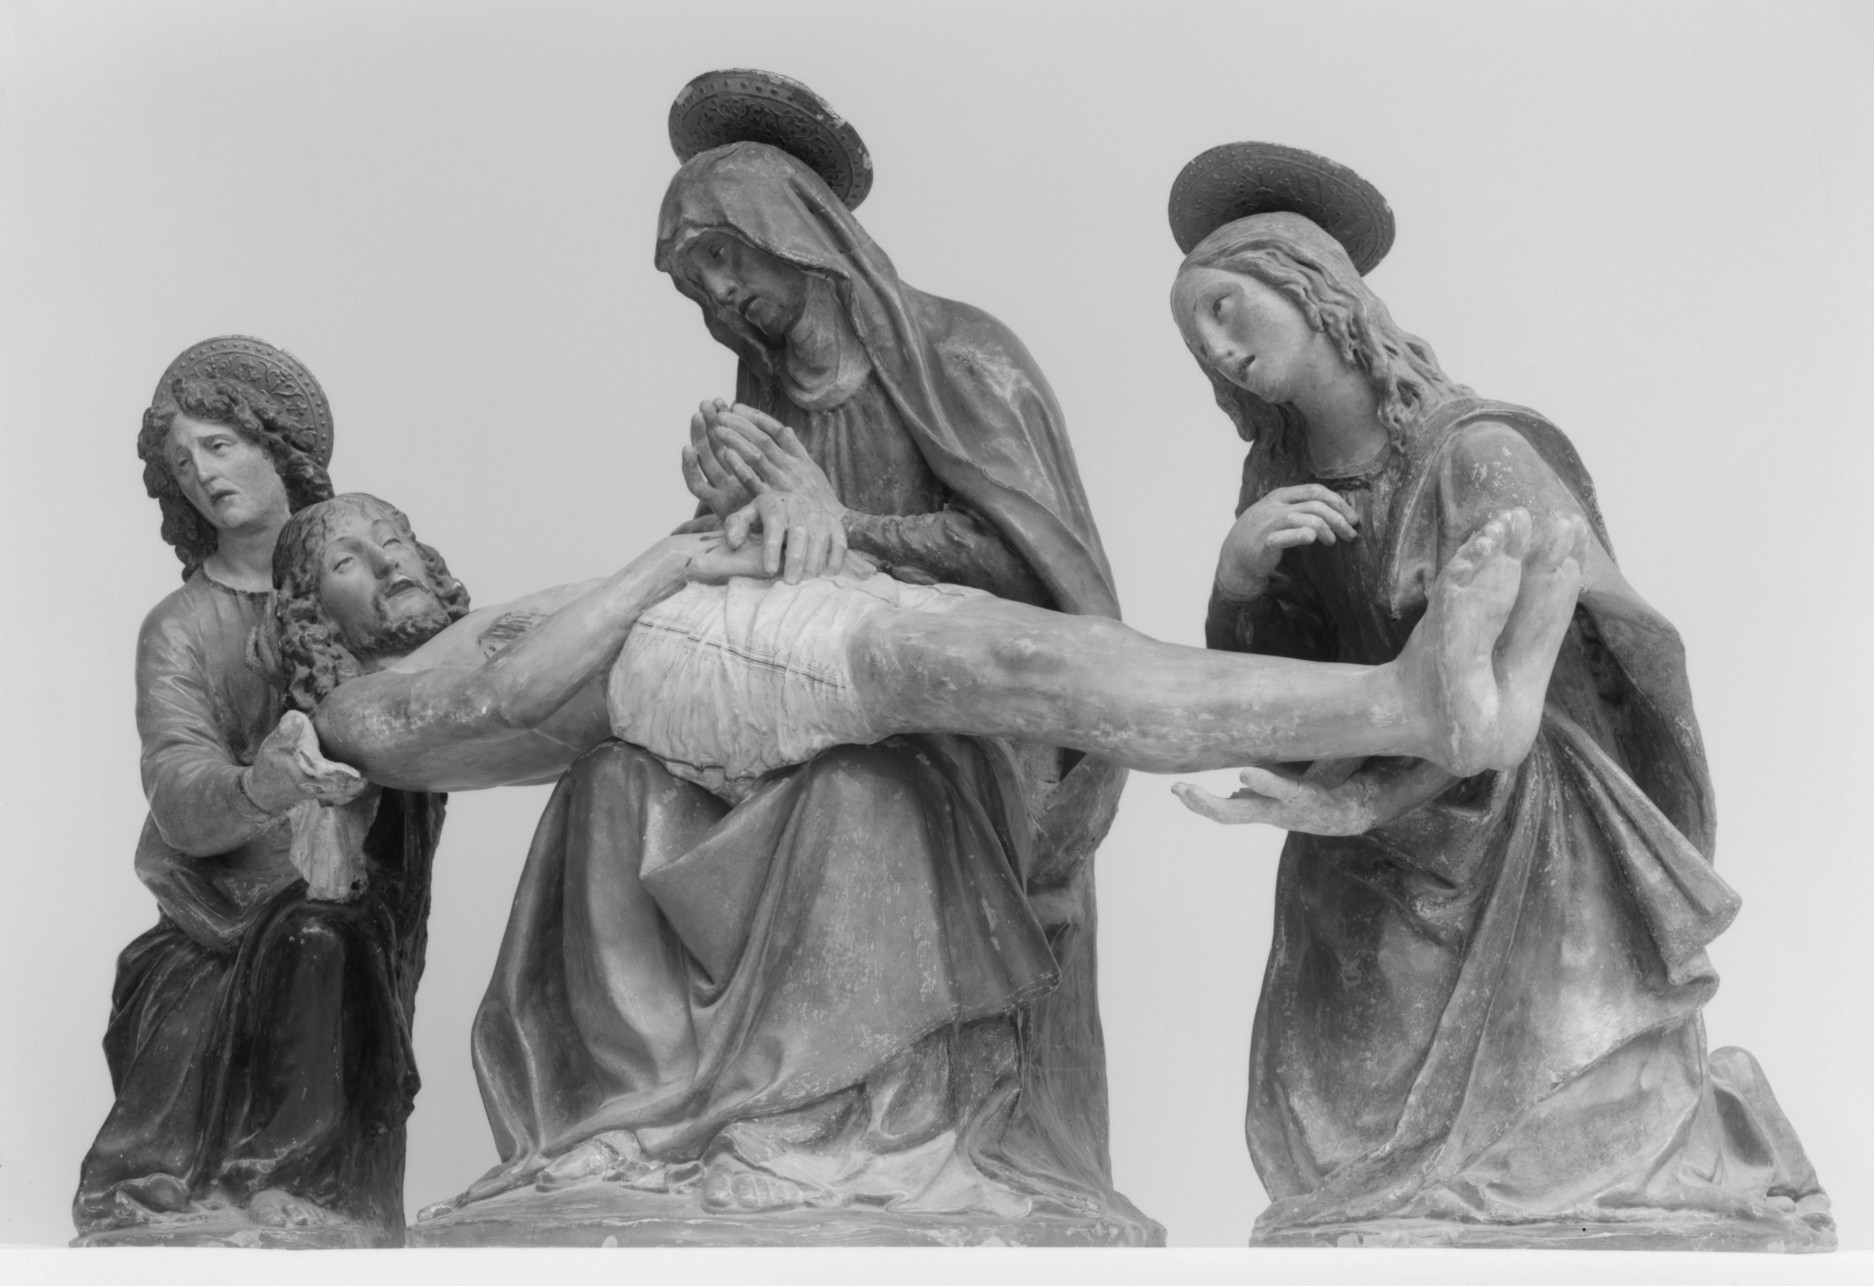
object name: group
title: Pietà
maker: giovanni della robbia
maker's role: artist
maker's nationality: italian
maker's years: 1469-1530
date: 1501-1533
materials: terracotta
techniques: painting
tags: christ,virgin mary,jesus,lamentation,death